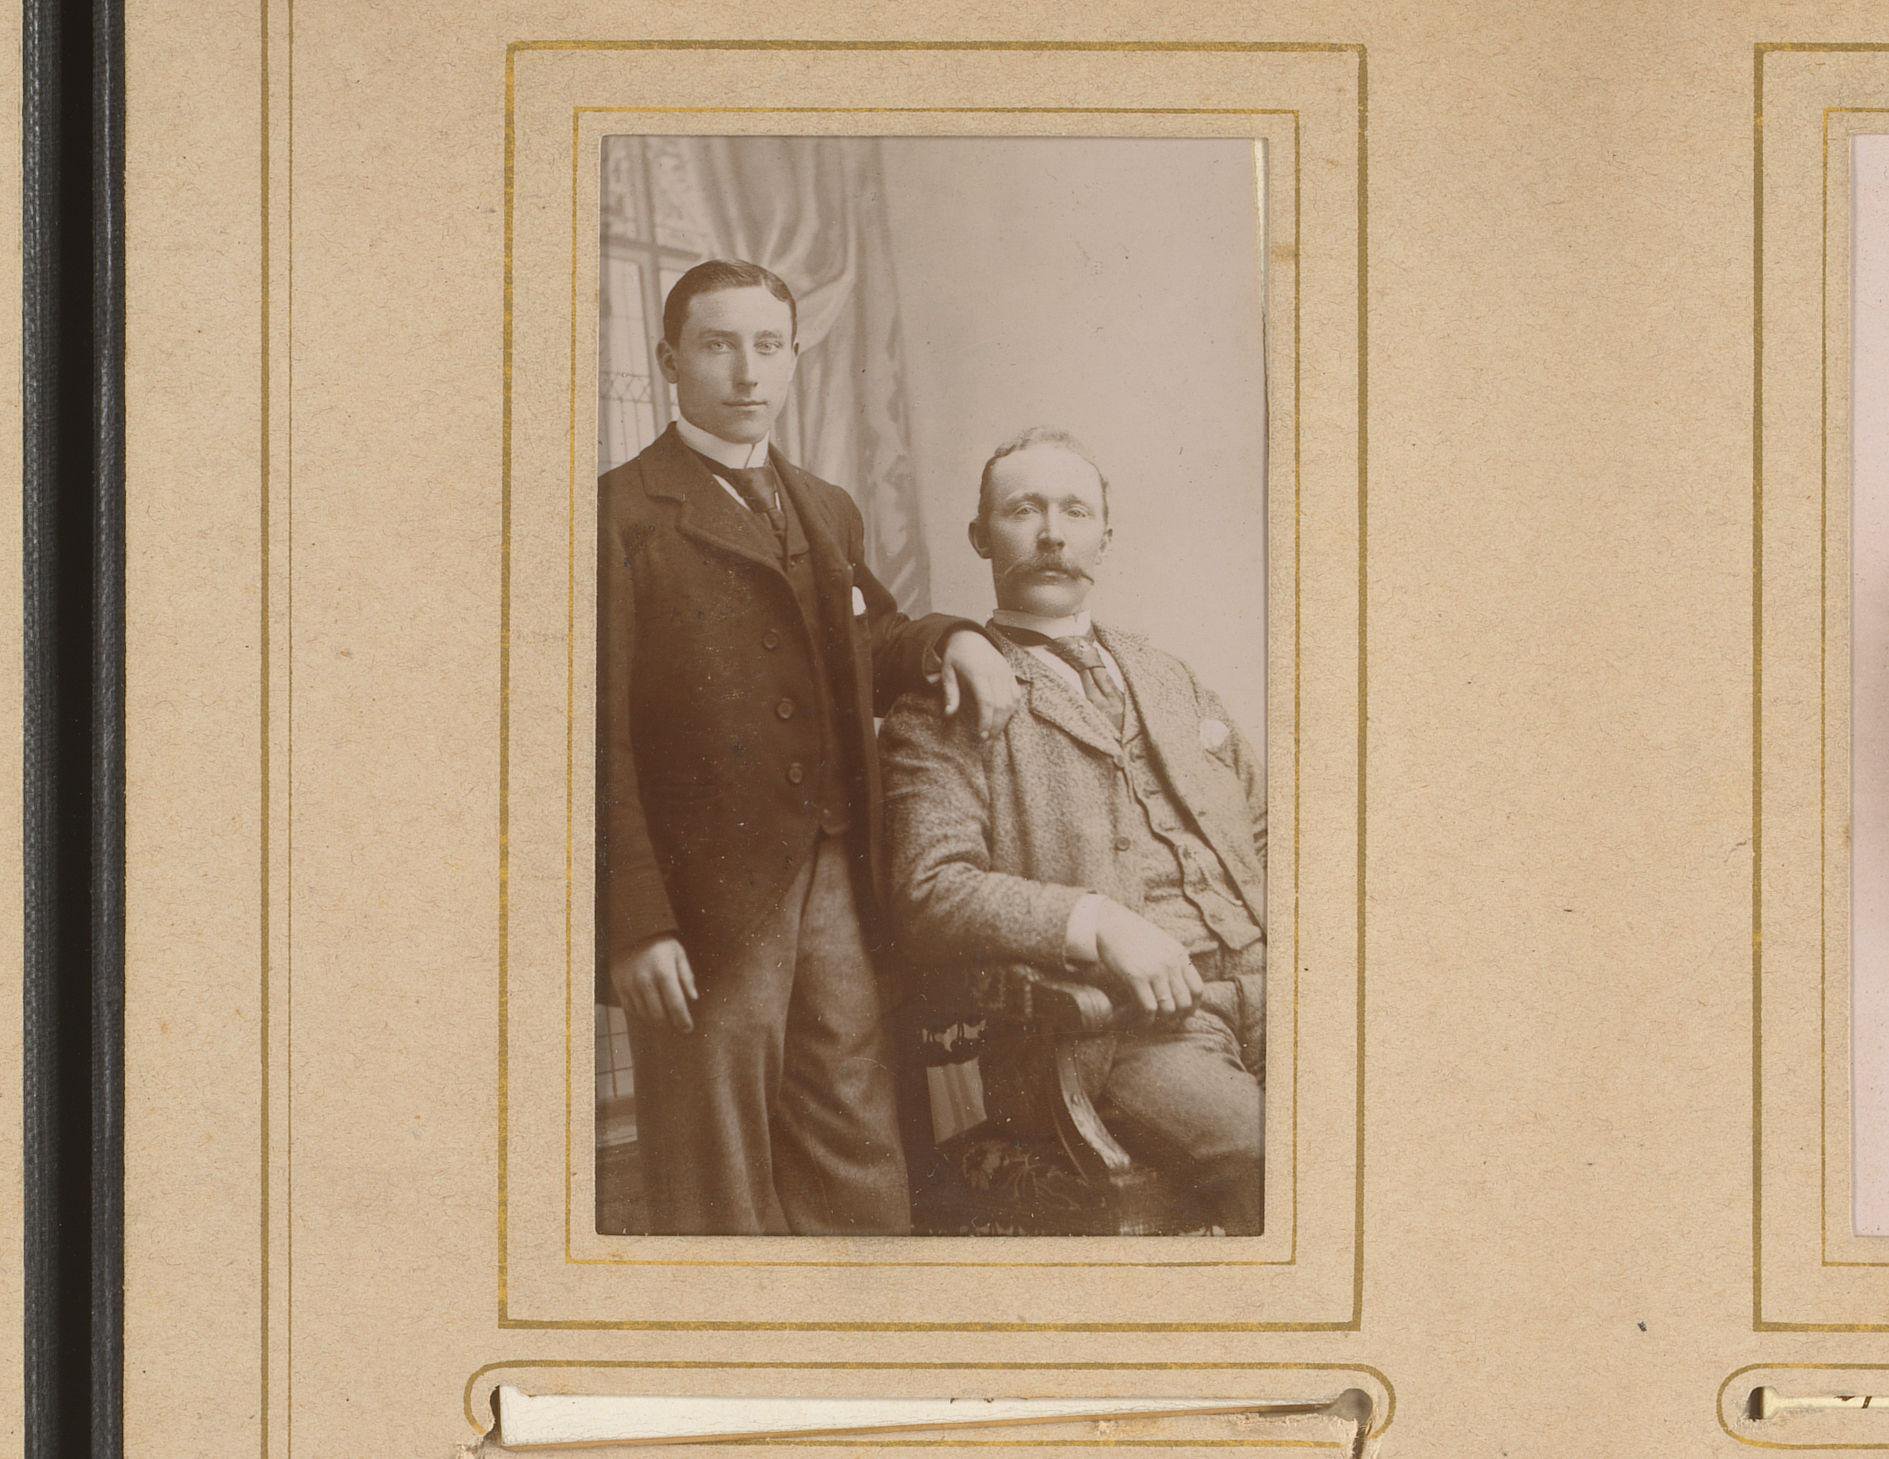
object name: carte de visite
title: Portret van twee mannen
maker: Anonymous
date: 1860-1900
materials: cardboard, photographic support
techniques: collodion silver print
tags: adult man, historical persons